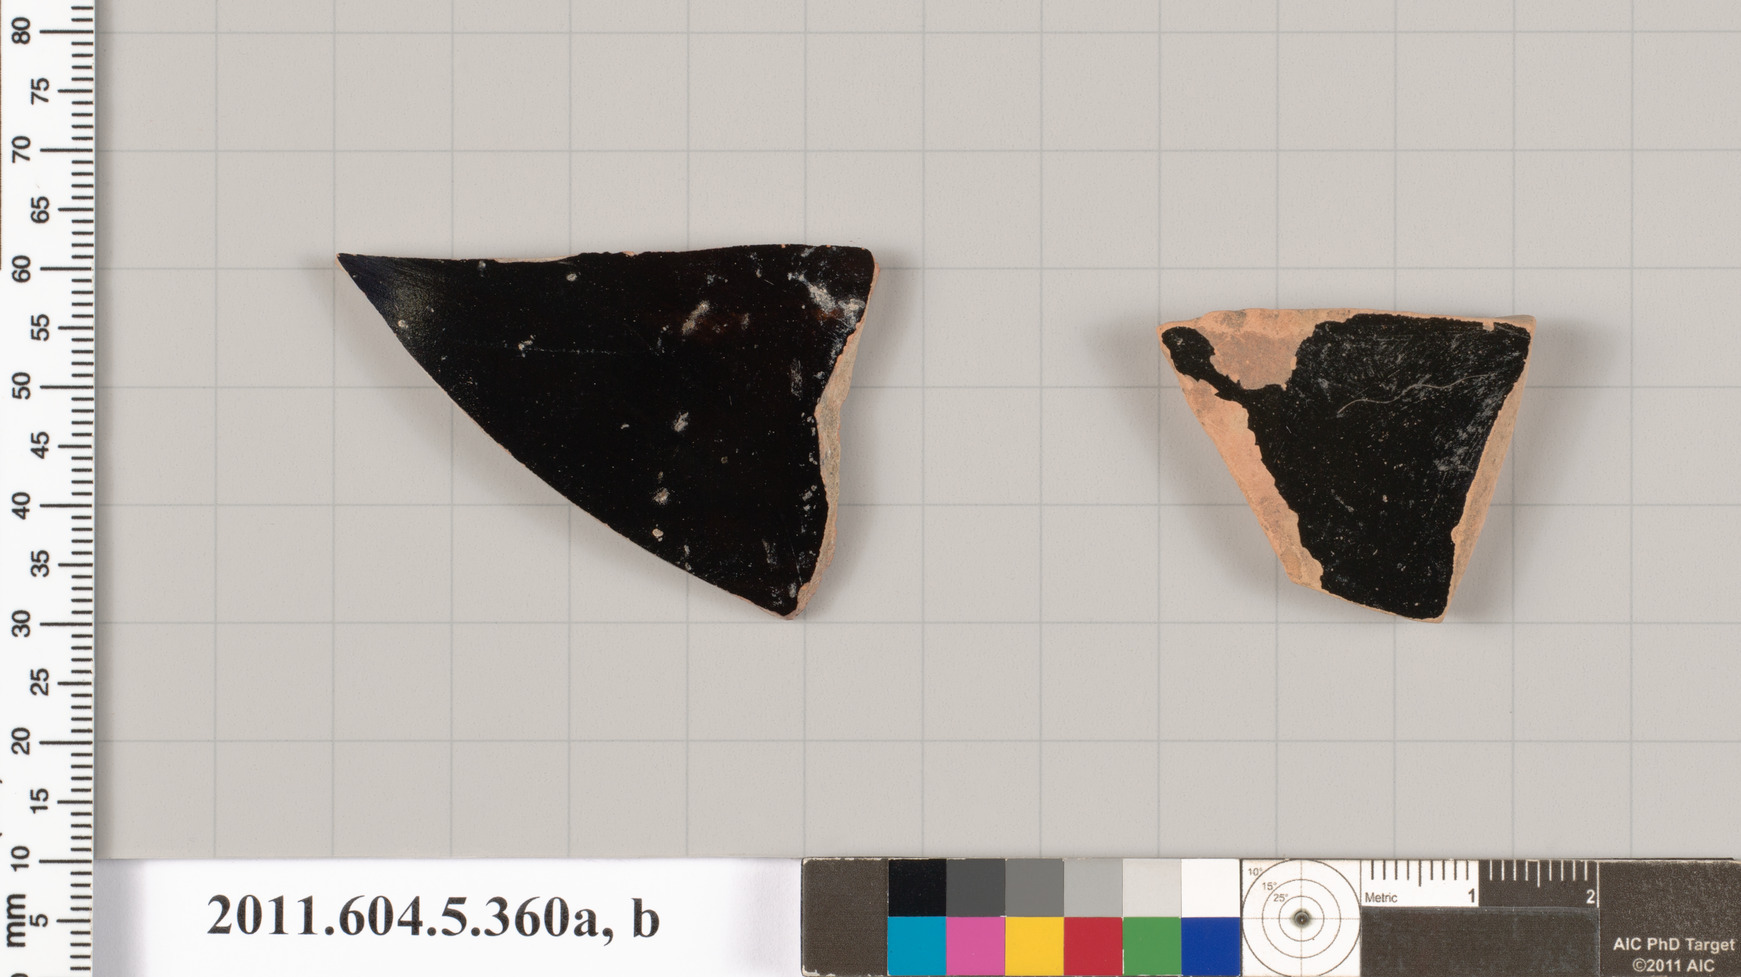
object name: kylix fragment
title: Terracotta fragments of kylikes (drinking cups)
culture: greek, attic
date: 600-401 BCE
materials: terracotta